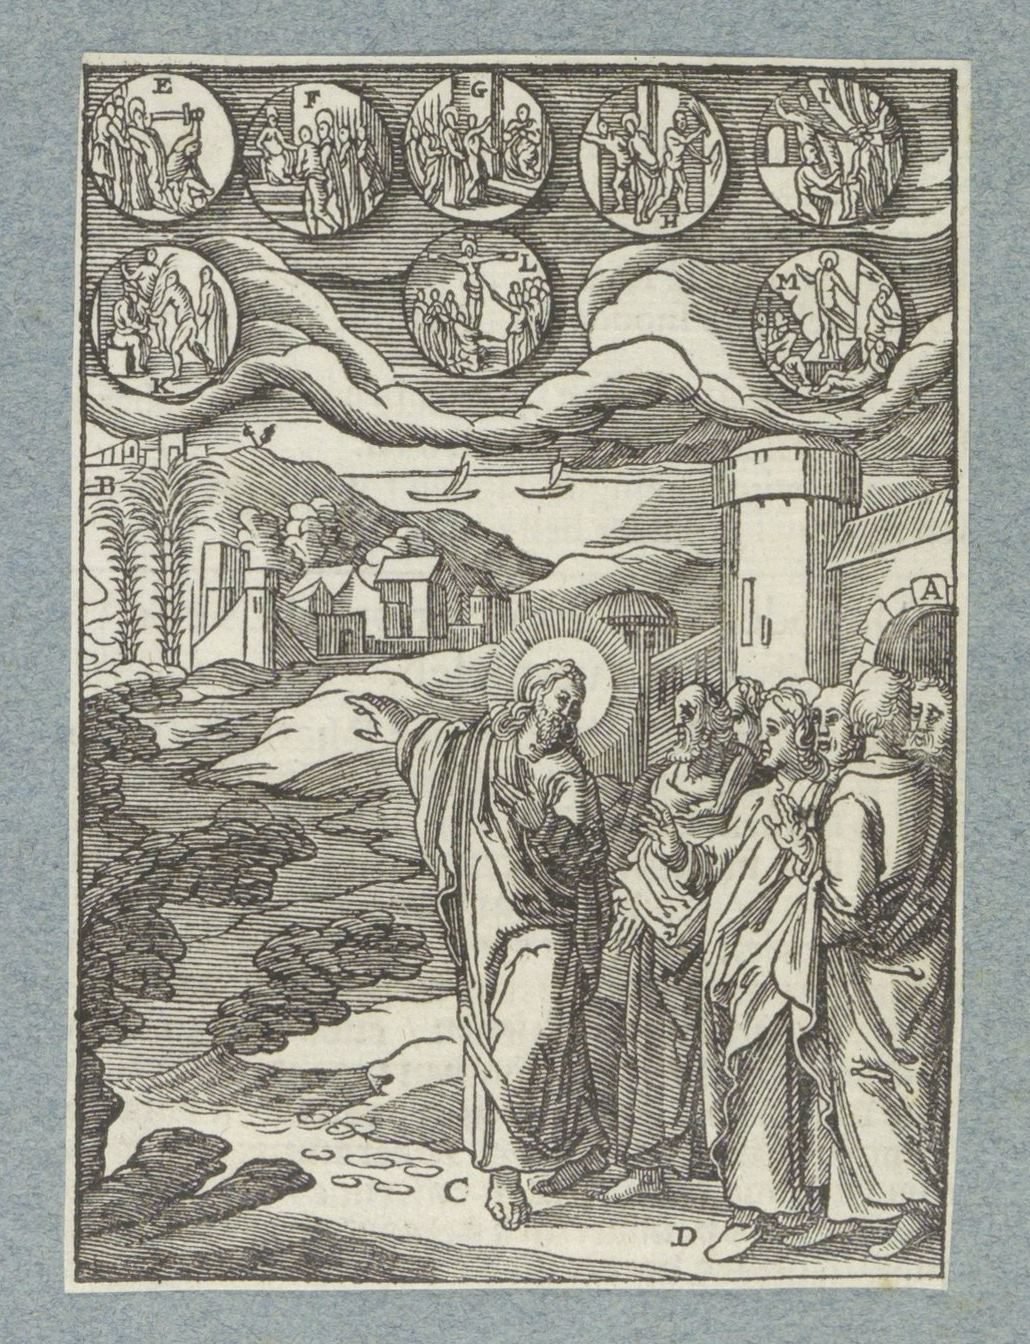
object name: print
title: Christus voorspelt zijn lijden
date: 1629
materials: paper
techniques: letterpress printing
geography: amsterdam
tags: christ's arrest, trial, and torture, christ foretelling his passion (at various occasions) (matthew 16:21, 17:22-23; mark 8:32, 9:31; luke 9:22, 9:44)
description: De prent is afkomstig uit een van de uitgaven van P.J. Paets uit Amsterdam. Ze wordt voor het eerst gebruikt in: Der Zielen Lust-hof. Leuven, I.Jacbosz voor P.J. Paets [= Amsterdam, P.J. Paets], 1629. De voorstelling is gekopieerd naar een prent van Antonie II Wierix voor: Nadal, Jerónimo. Evangelicae Historiae Imagines. Antwerpen, M. Nutius, 1593.